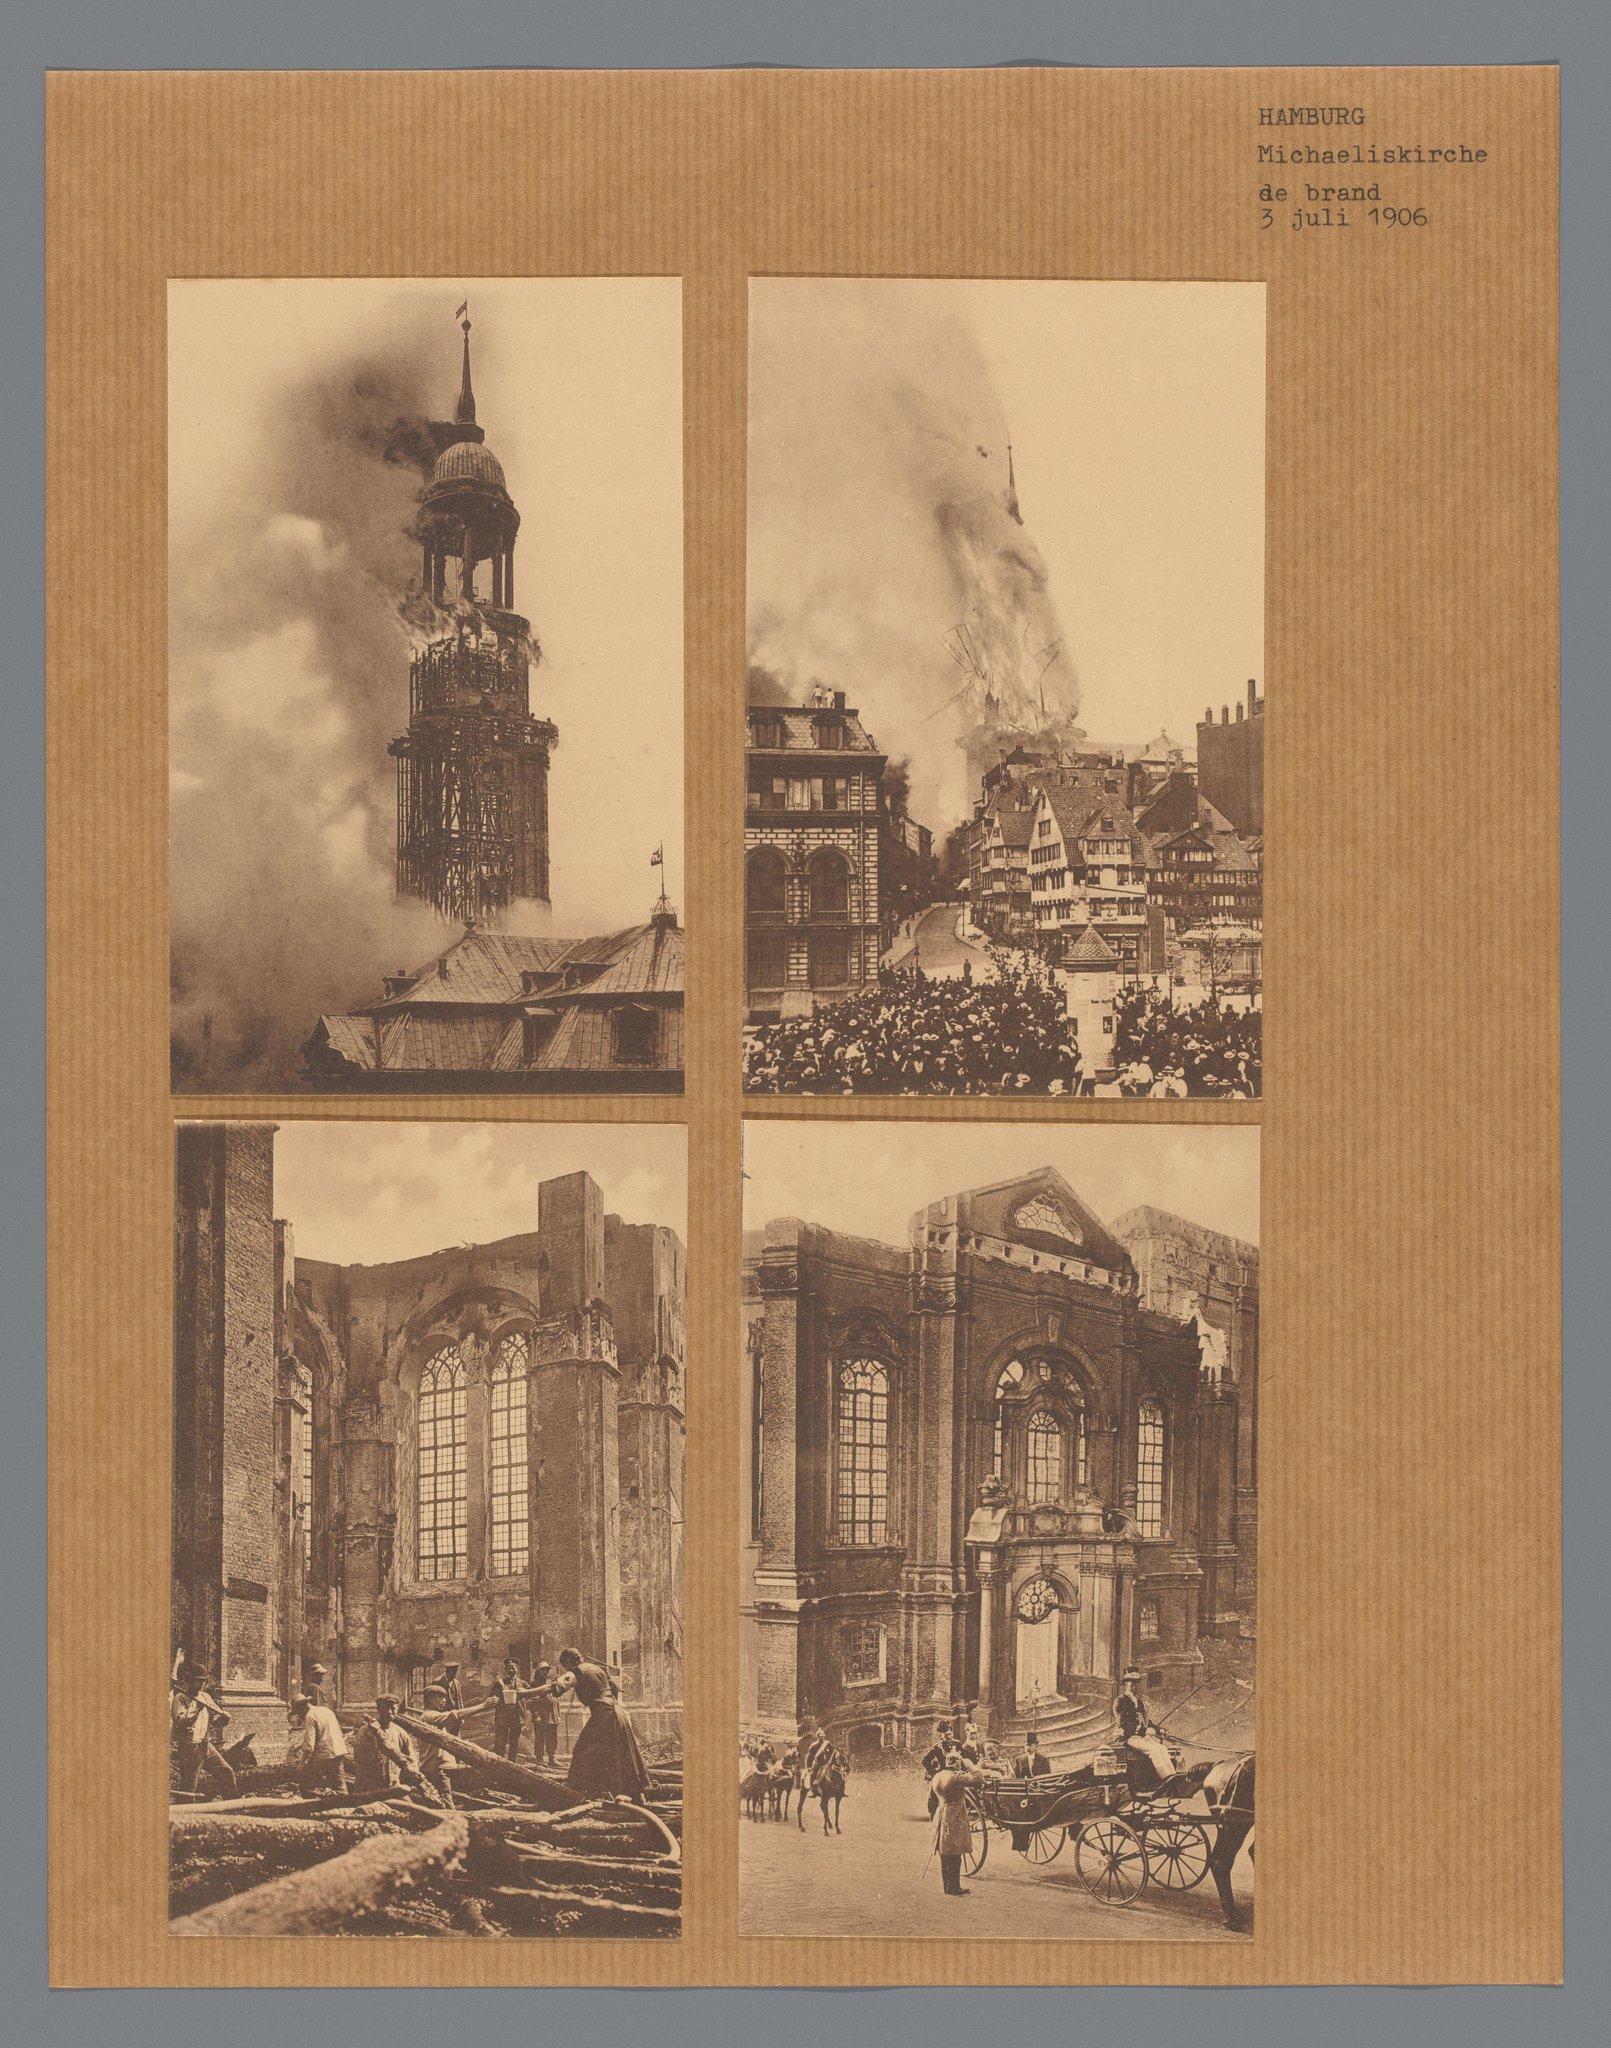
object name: photograph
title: Hamburg, Michaeliskirche, de brand 3 juli 1906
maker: Anonymous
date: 1880-1920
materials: paper, photographic support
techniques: photograph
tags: hamburg